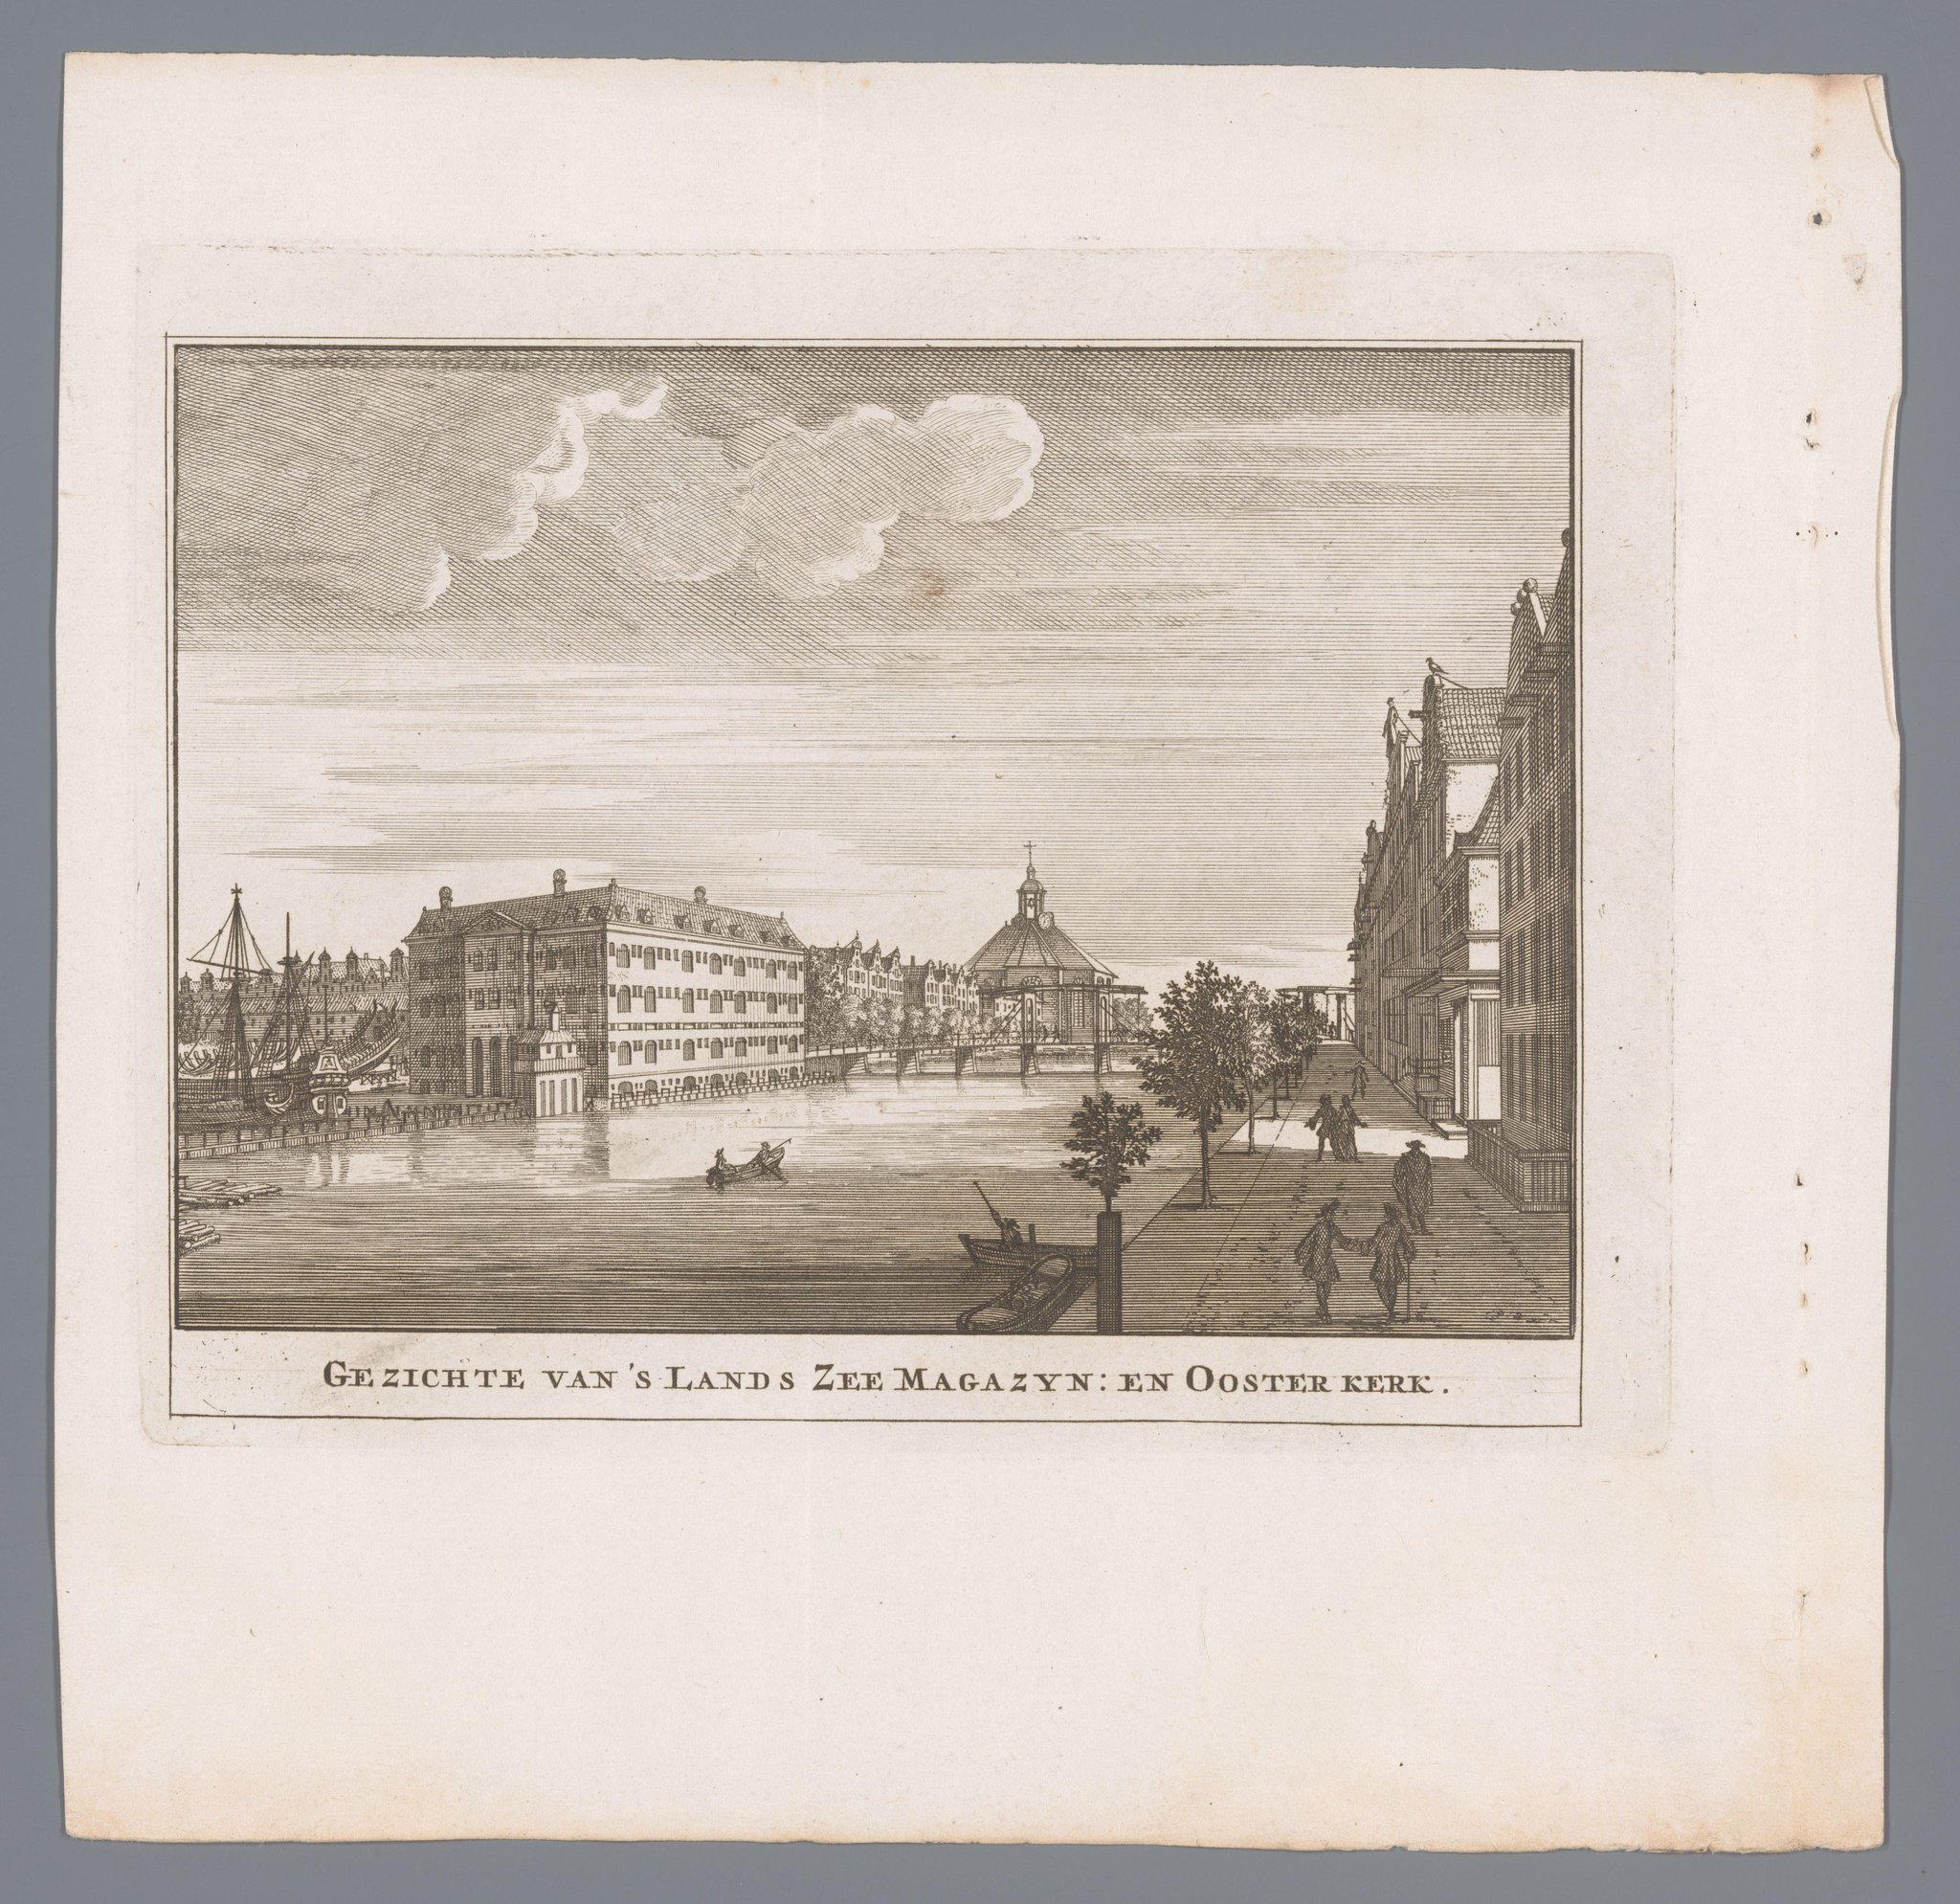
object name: print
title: Gezichte van 's Lands Zee Magazyn: en Ooster kerk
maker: Anonymous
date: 1675-1700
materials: paper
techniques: engraving, etching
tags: large-scale structure for storage, e.g.: warehouse, depot, silo, civic architecture; edifices; dwellings, ammunition store, arsenal